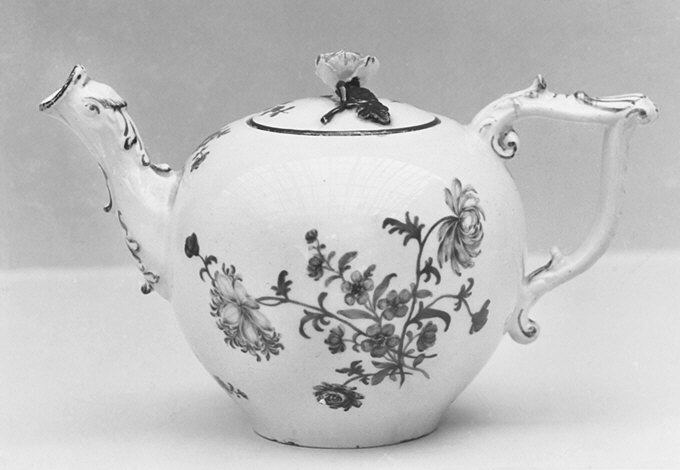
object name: teapot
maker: meissen manufactory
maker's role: manufactory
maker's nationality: german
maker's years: 1710-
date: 1740-1750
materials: hard paste porcelain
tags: flowers